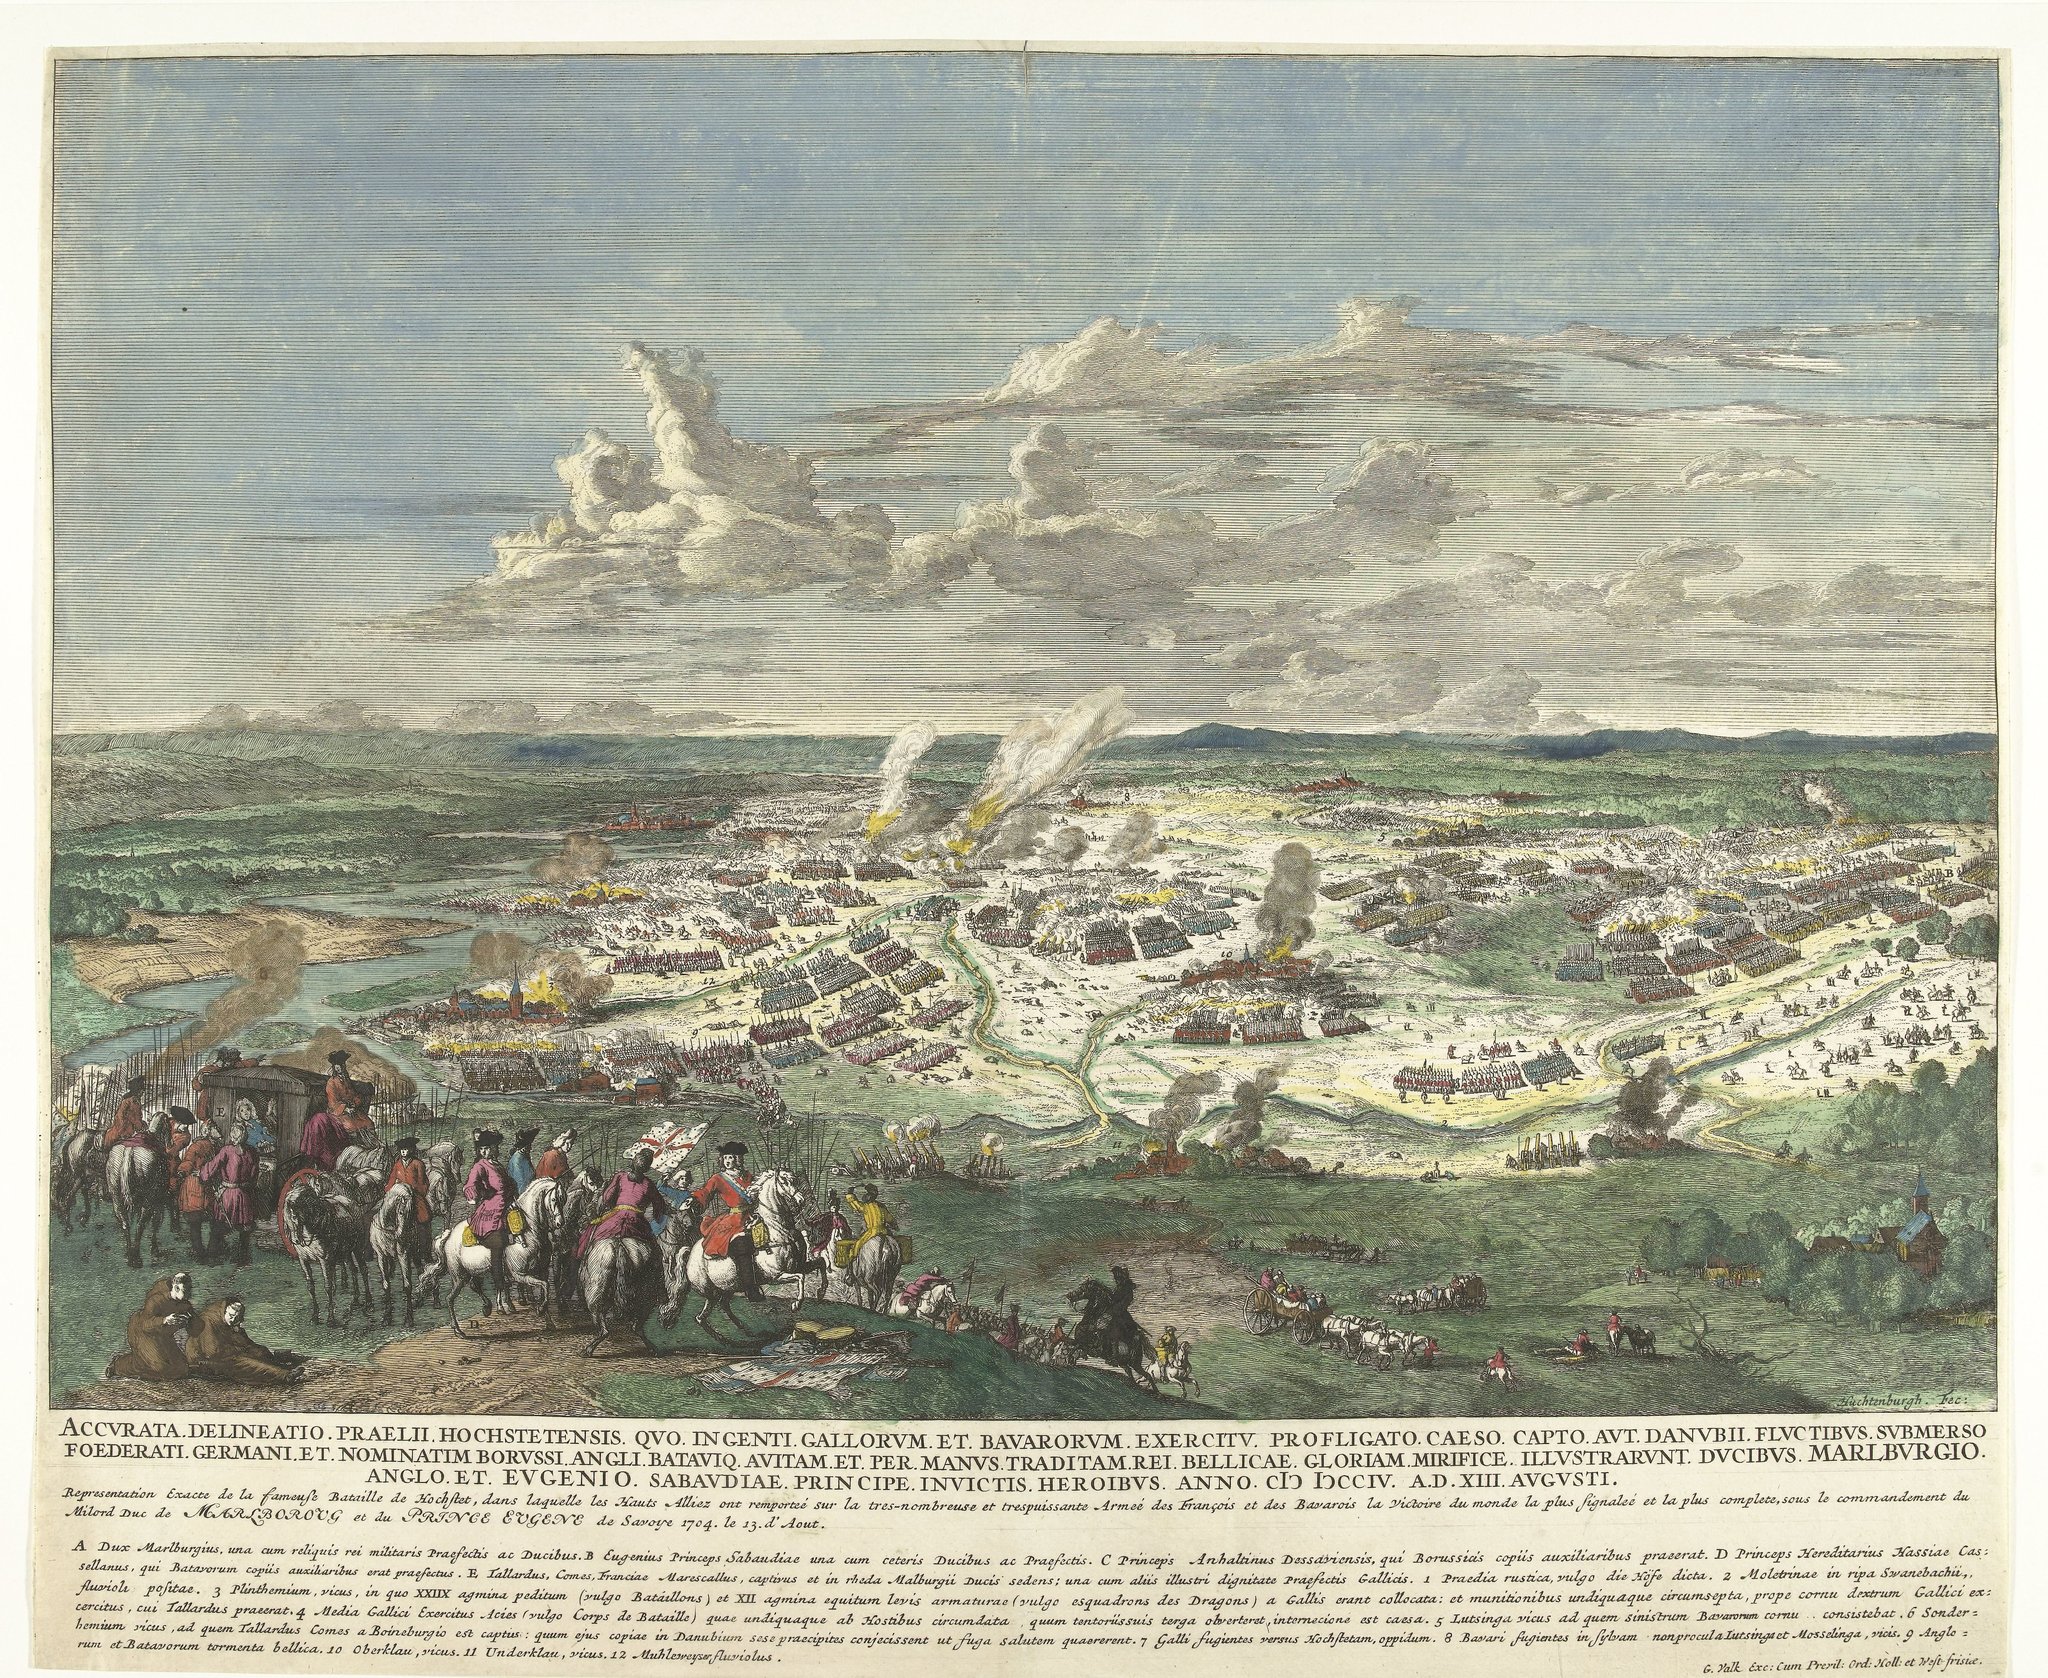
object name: print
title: Accurata. Delineatio. Praelii. Hochstetensis. quo. Ingenti. Gallorum. et. Batavorum. (...) / Representation Exacte de la Fameuse Bataille de Hochstet, dans laquelle les Hauts Alliez ont remporté (...) 1704. le 13. d'Aout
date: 1704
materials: paper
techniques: etching, hand coloring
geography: northern netherlands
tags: paris, vienna, eugenius van savoye, john churchill (1e hertog van marlborough), battle (+ land forces)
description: Grote voorstelling van de slag bij Höchstädt (slag bij Blenheim) met een overwinning van de Geallieerden op de Fransen, 13 augustus 1704. Op de voorgrond prins Eugenius en de hertog van Marlborough, met de duc de Tallard gevangen zittend in de koets van Marlborough. Met onderschrift in het Latijn en Frans.